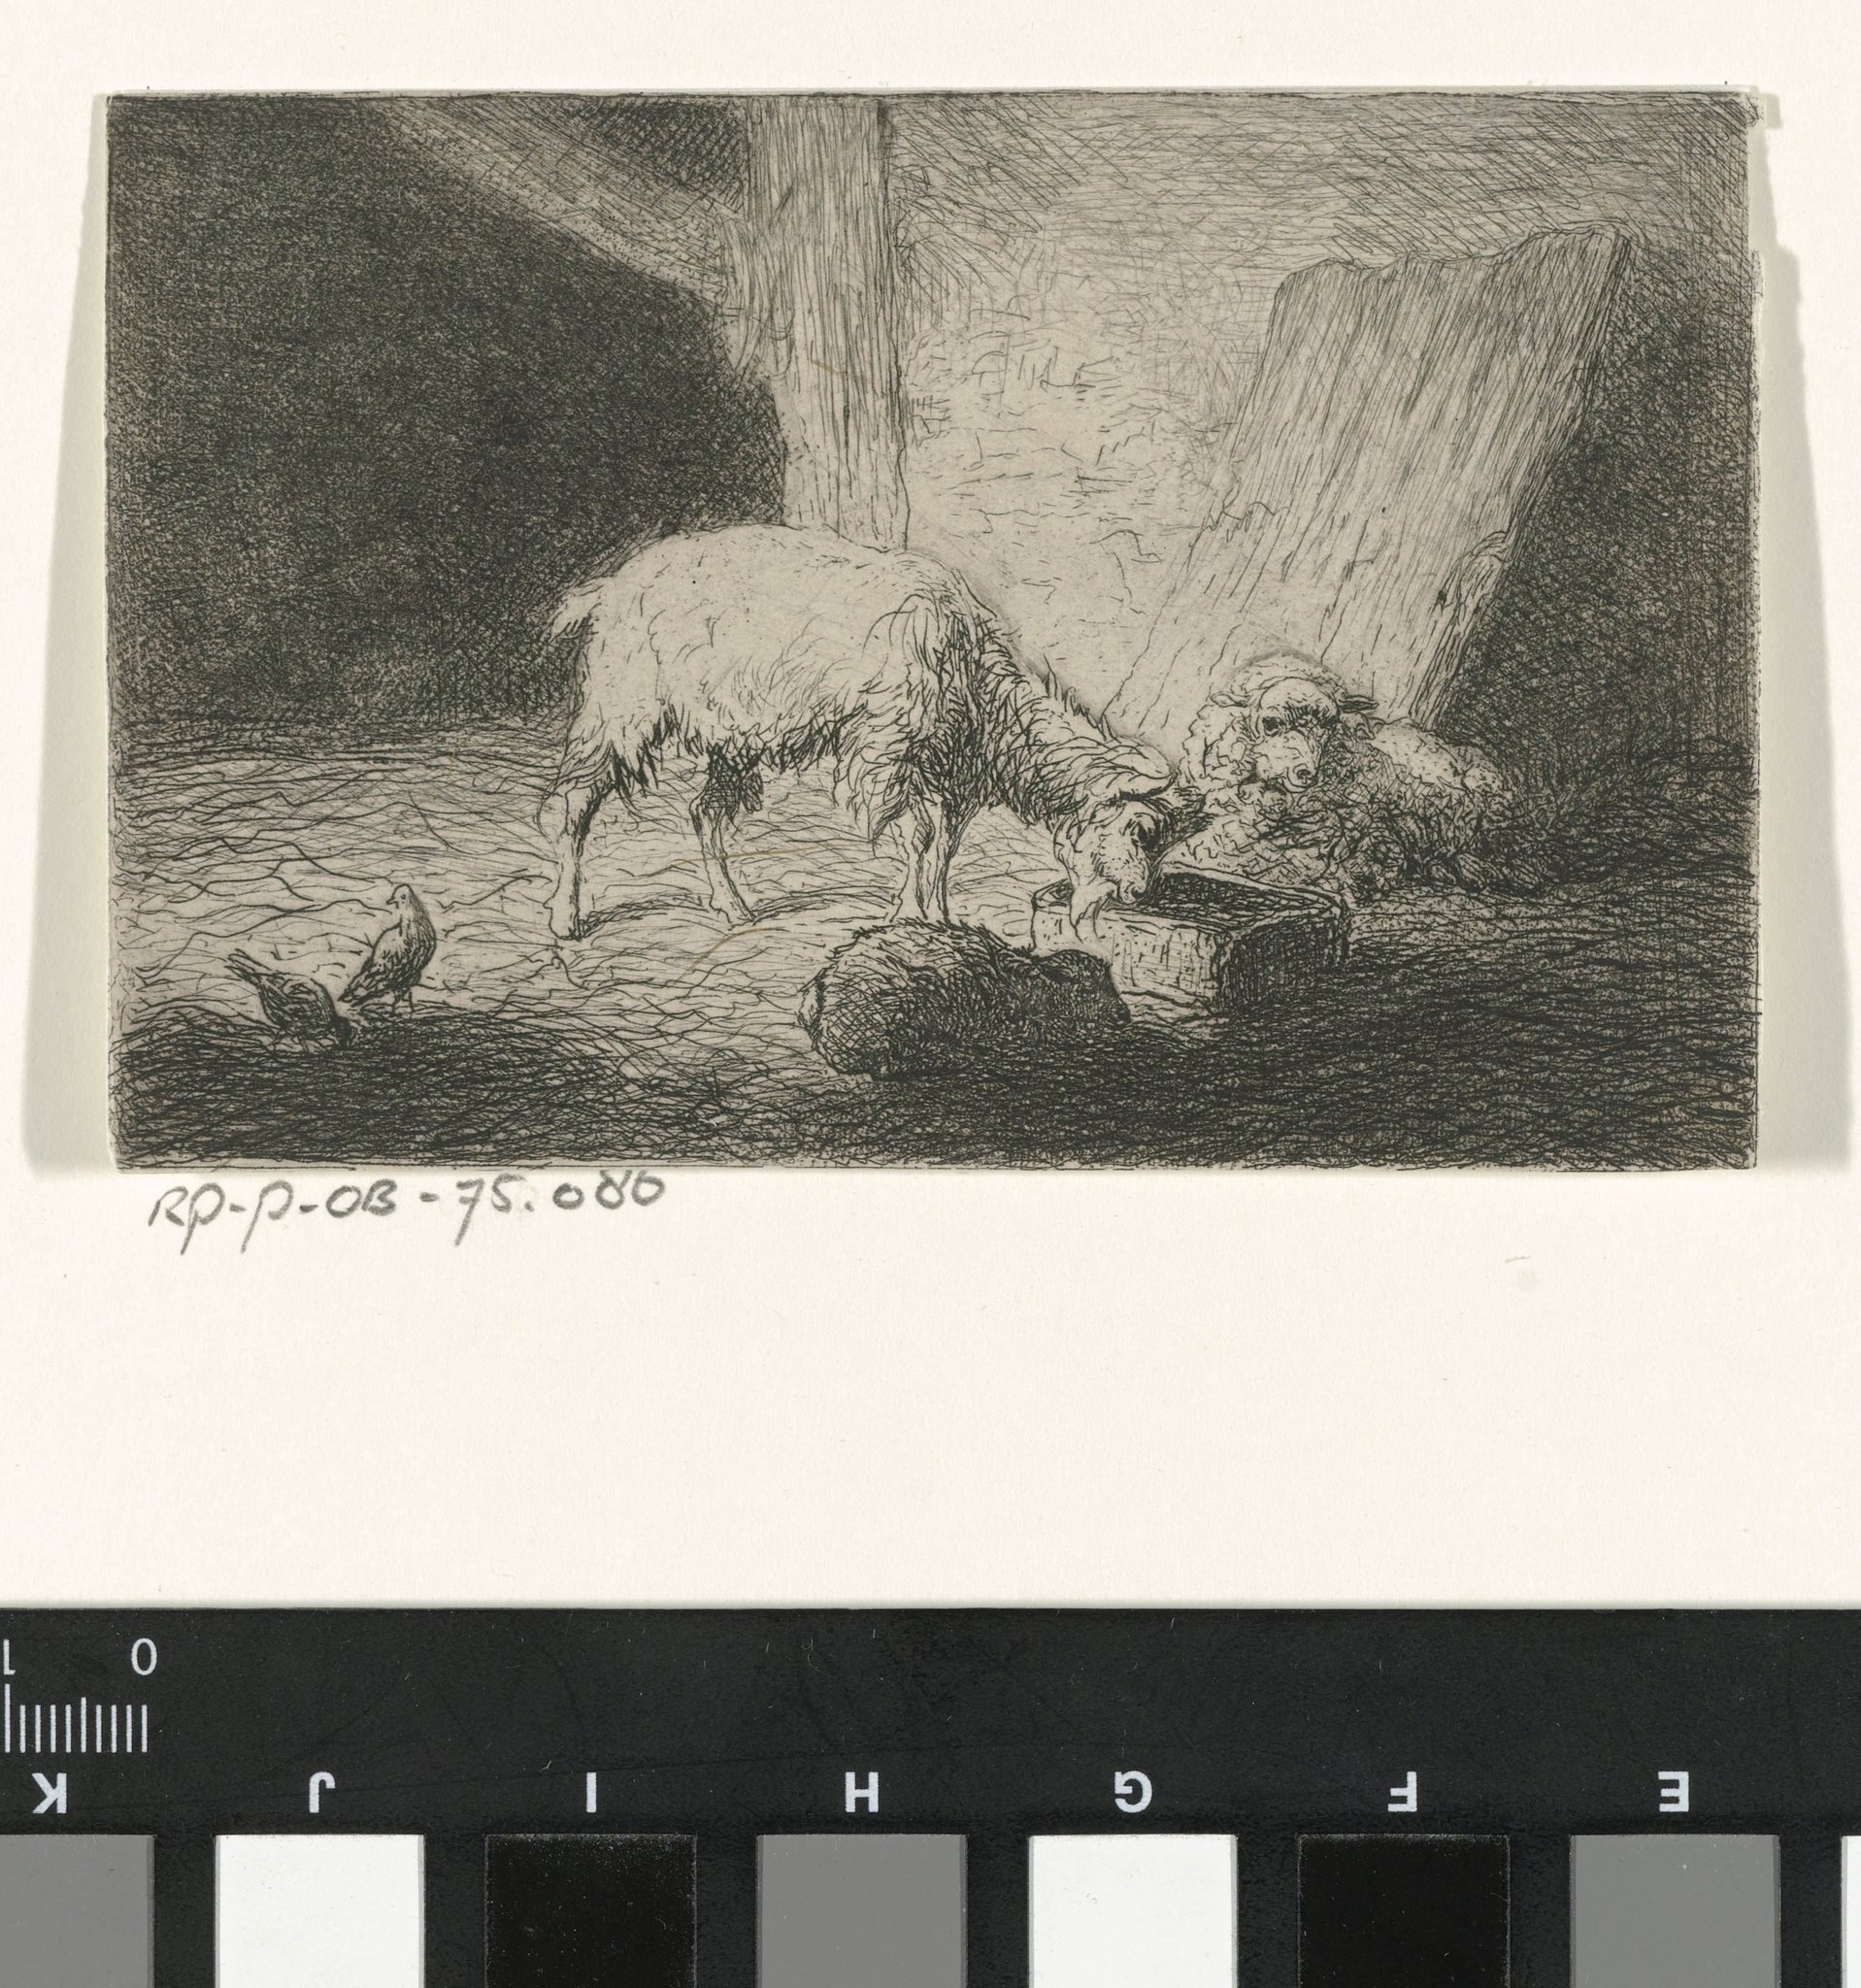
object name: print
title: Twee schapen en een geit in een stal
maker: Anonymous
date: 1650-1799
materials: paper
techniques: etching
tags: barn, sheep, goat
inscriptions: collector's mark: Lugt 2228